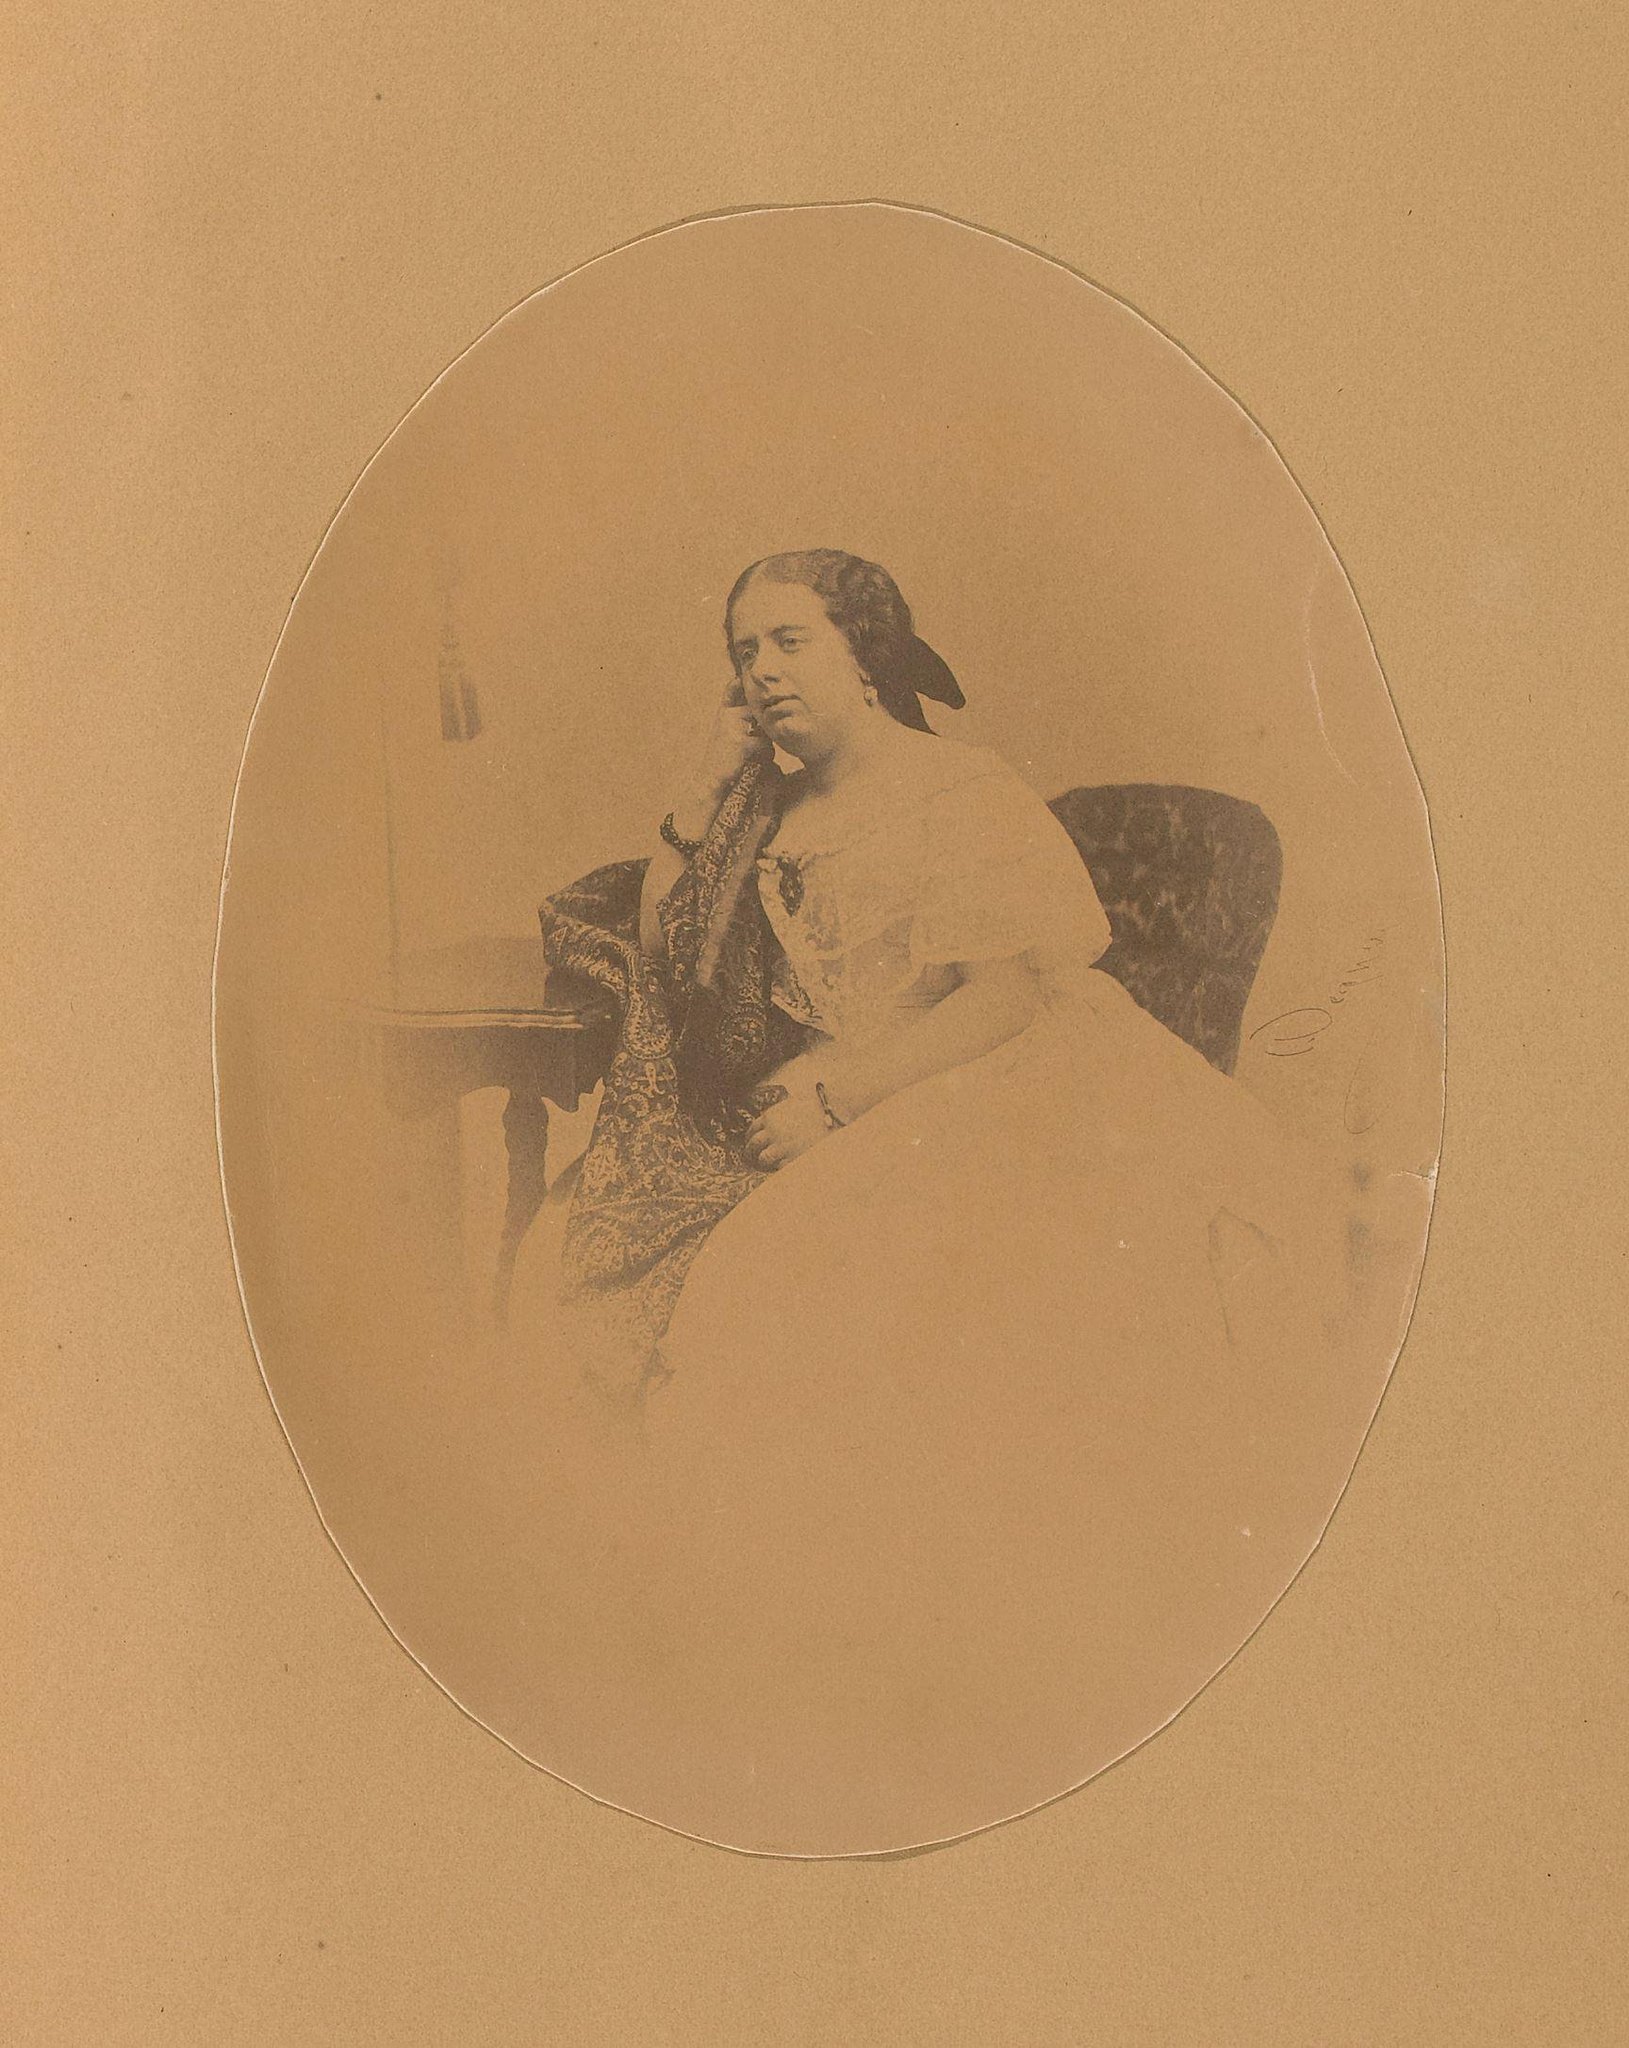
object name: photograph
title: Portret van Caroline Asser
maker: louis wegner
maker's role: print maker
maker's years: 1816-1864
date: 1856-1858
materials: cardboard, paper, photographic support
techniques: salted paper print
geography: amsterdam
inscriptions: signature: ‘Wegner’